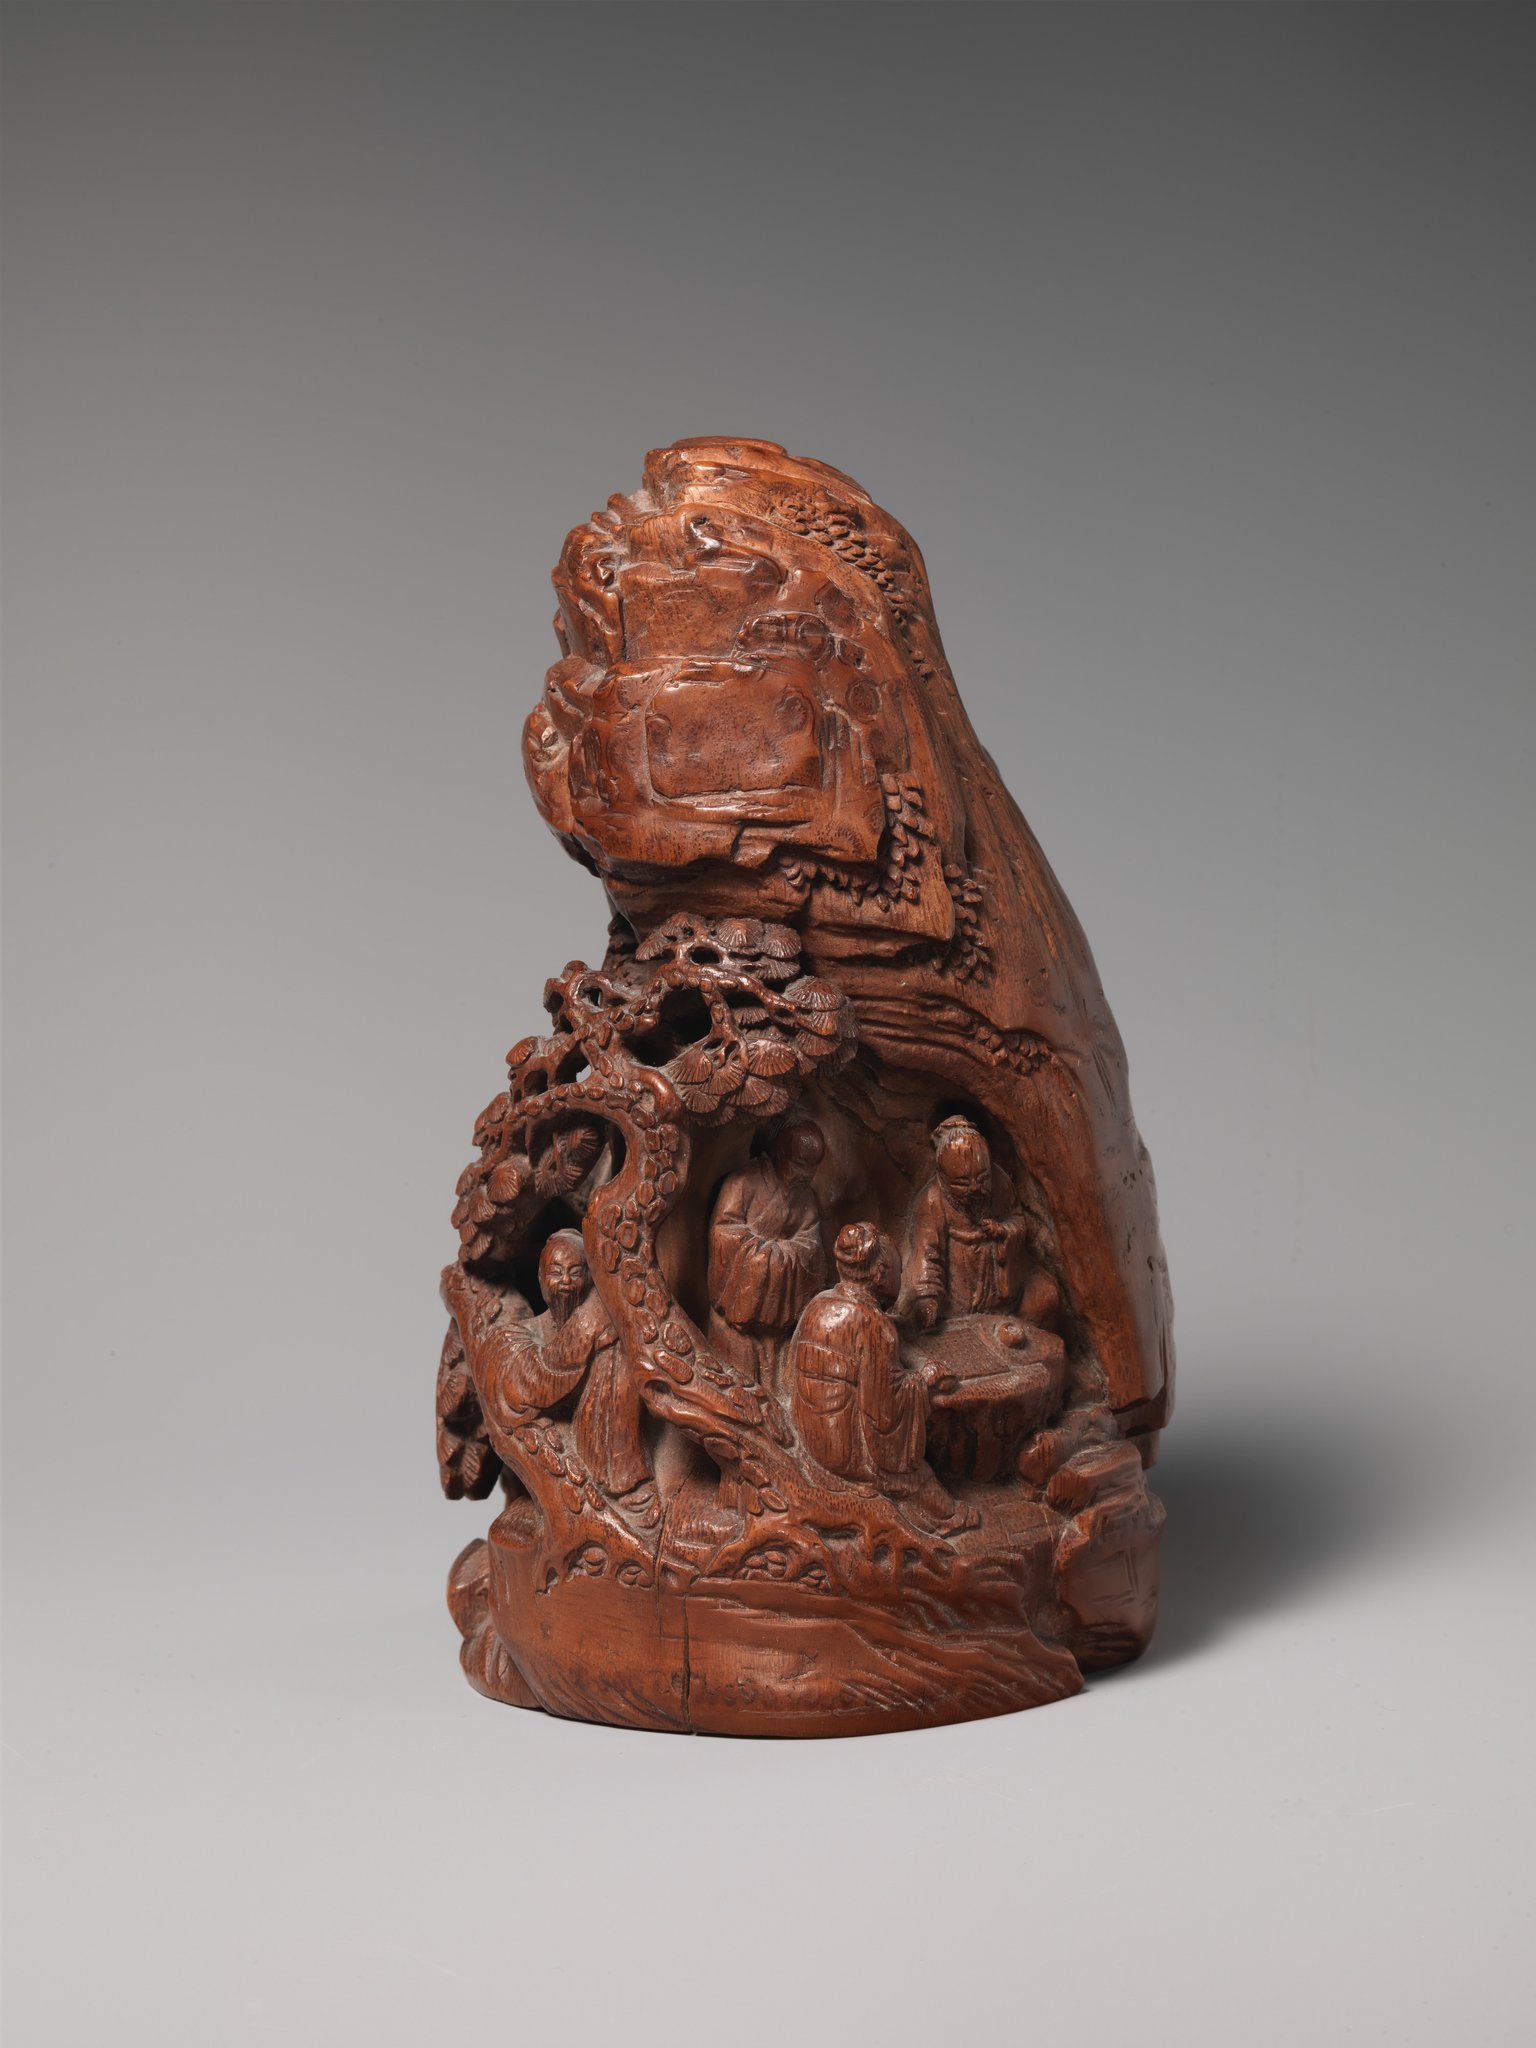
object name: figure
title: Chess playing in an immortal realm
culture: chinese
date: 1801-1900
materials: bamboo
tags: men